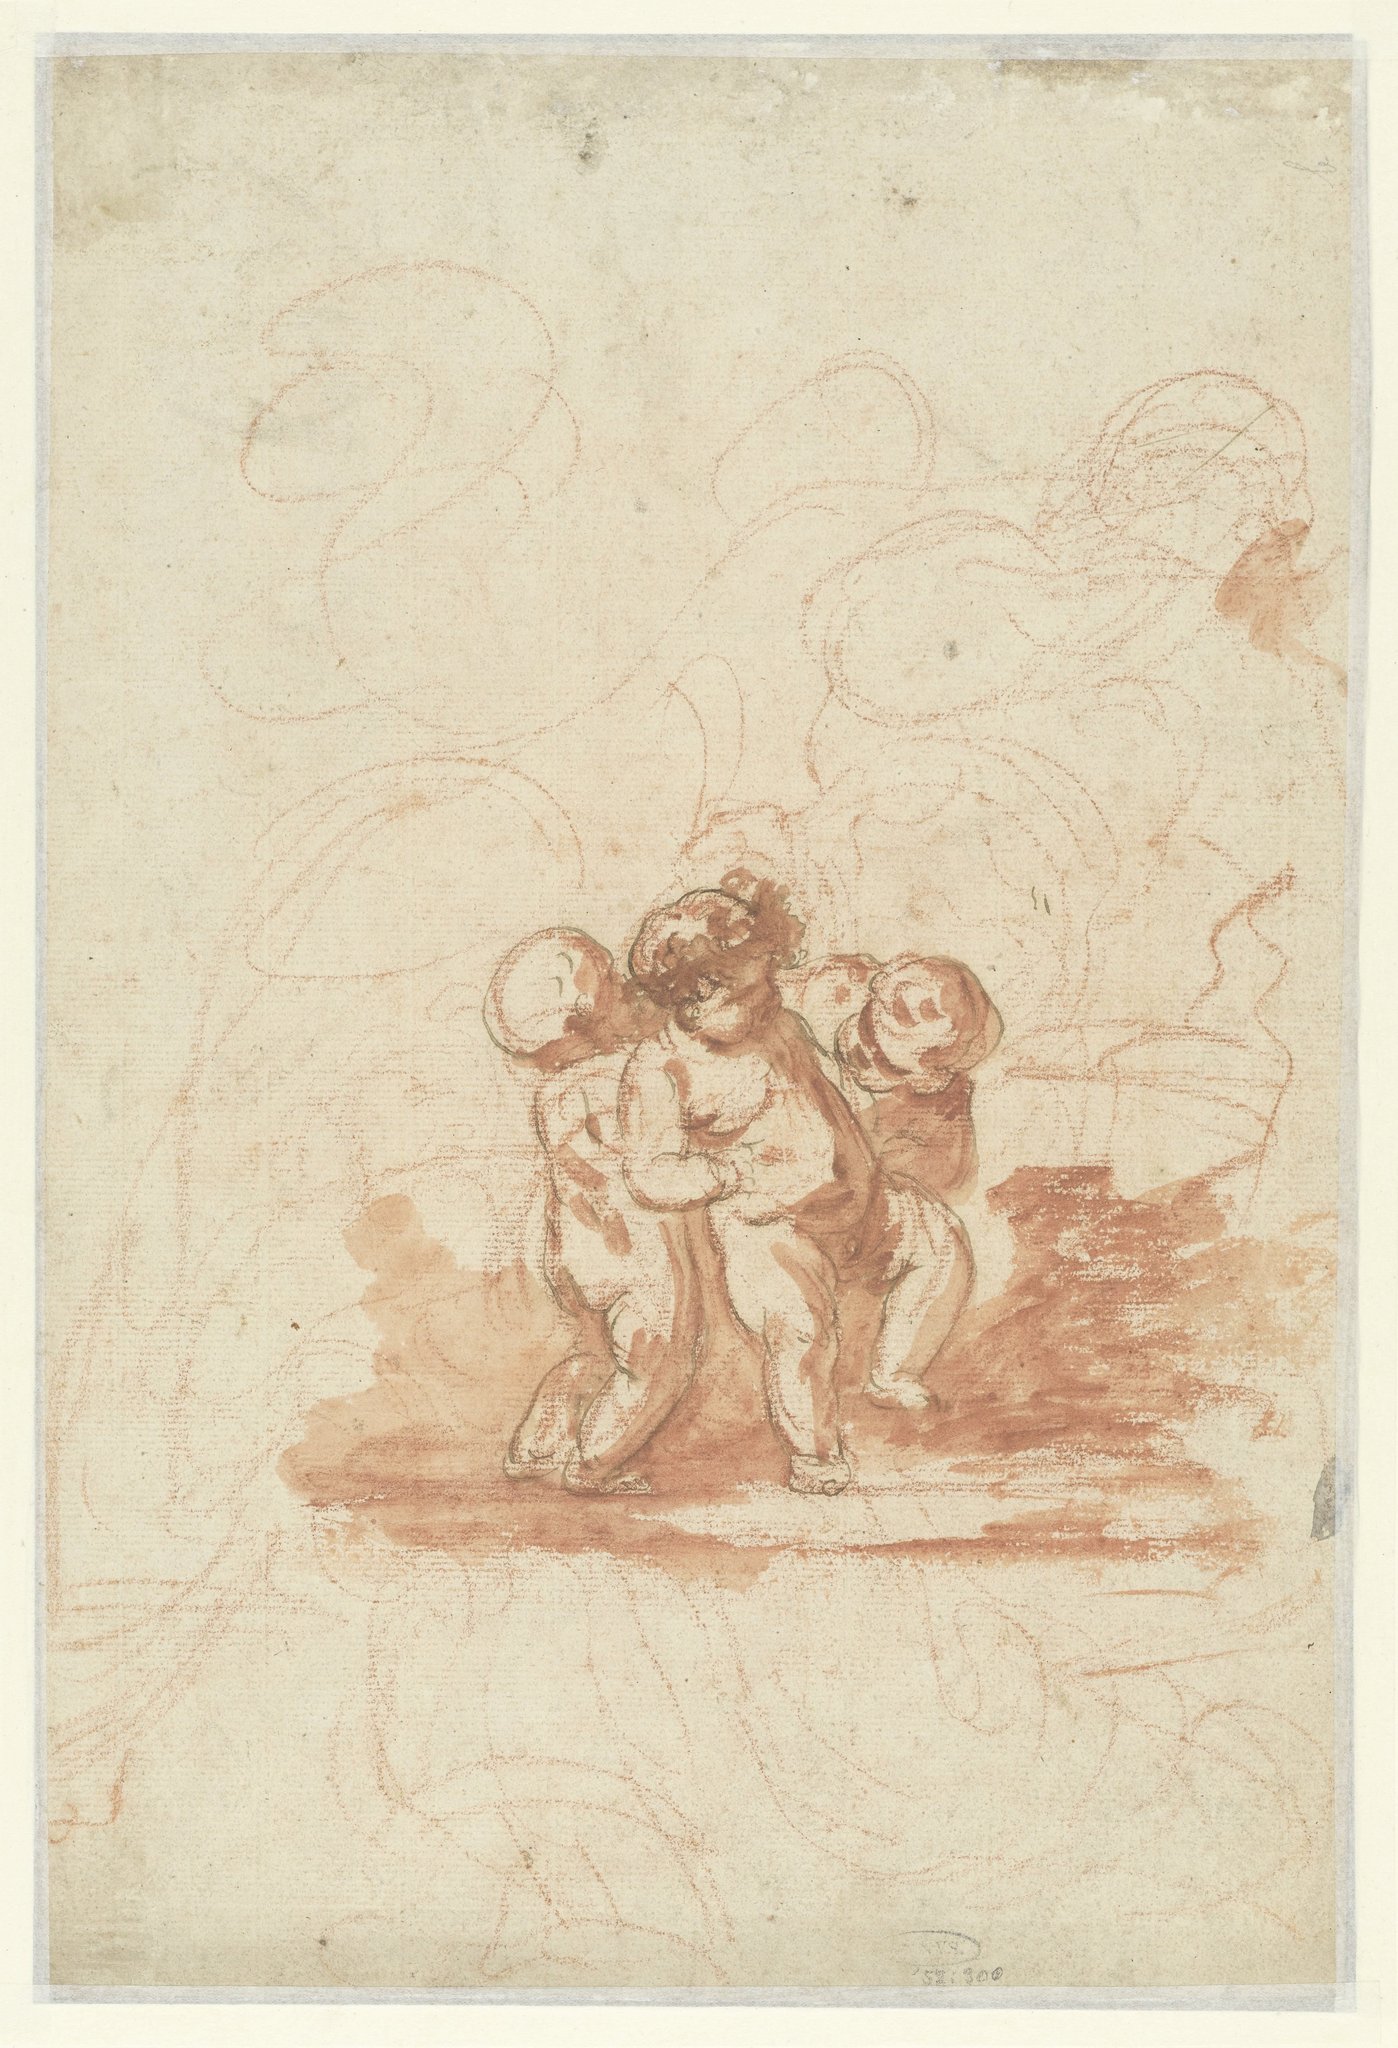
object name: drawing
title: Drie putti in een landschap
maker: Anonymous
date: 1700-1800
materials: chalk, ink, paper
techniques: brush, pen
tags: cupids: 'amores', 'amoretti', 'putti'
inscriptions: collector's mark: Lugt 22288